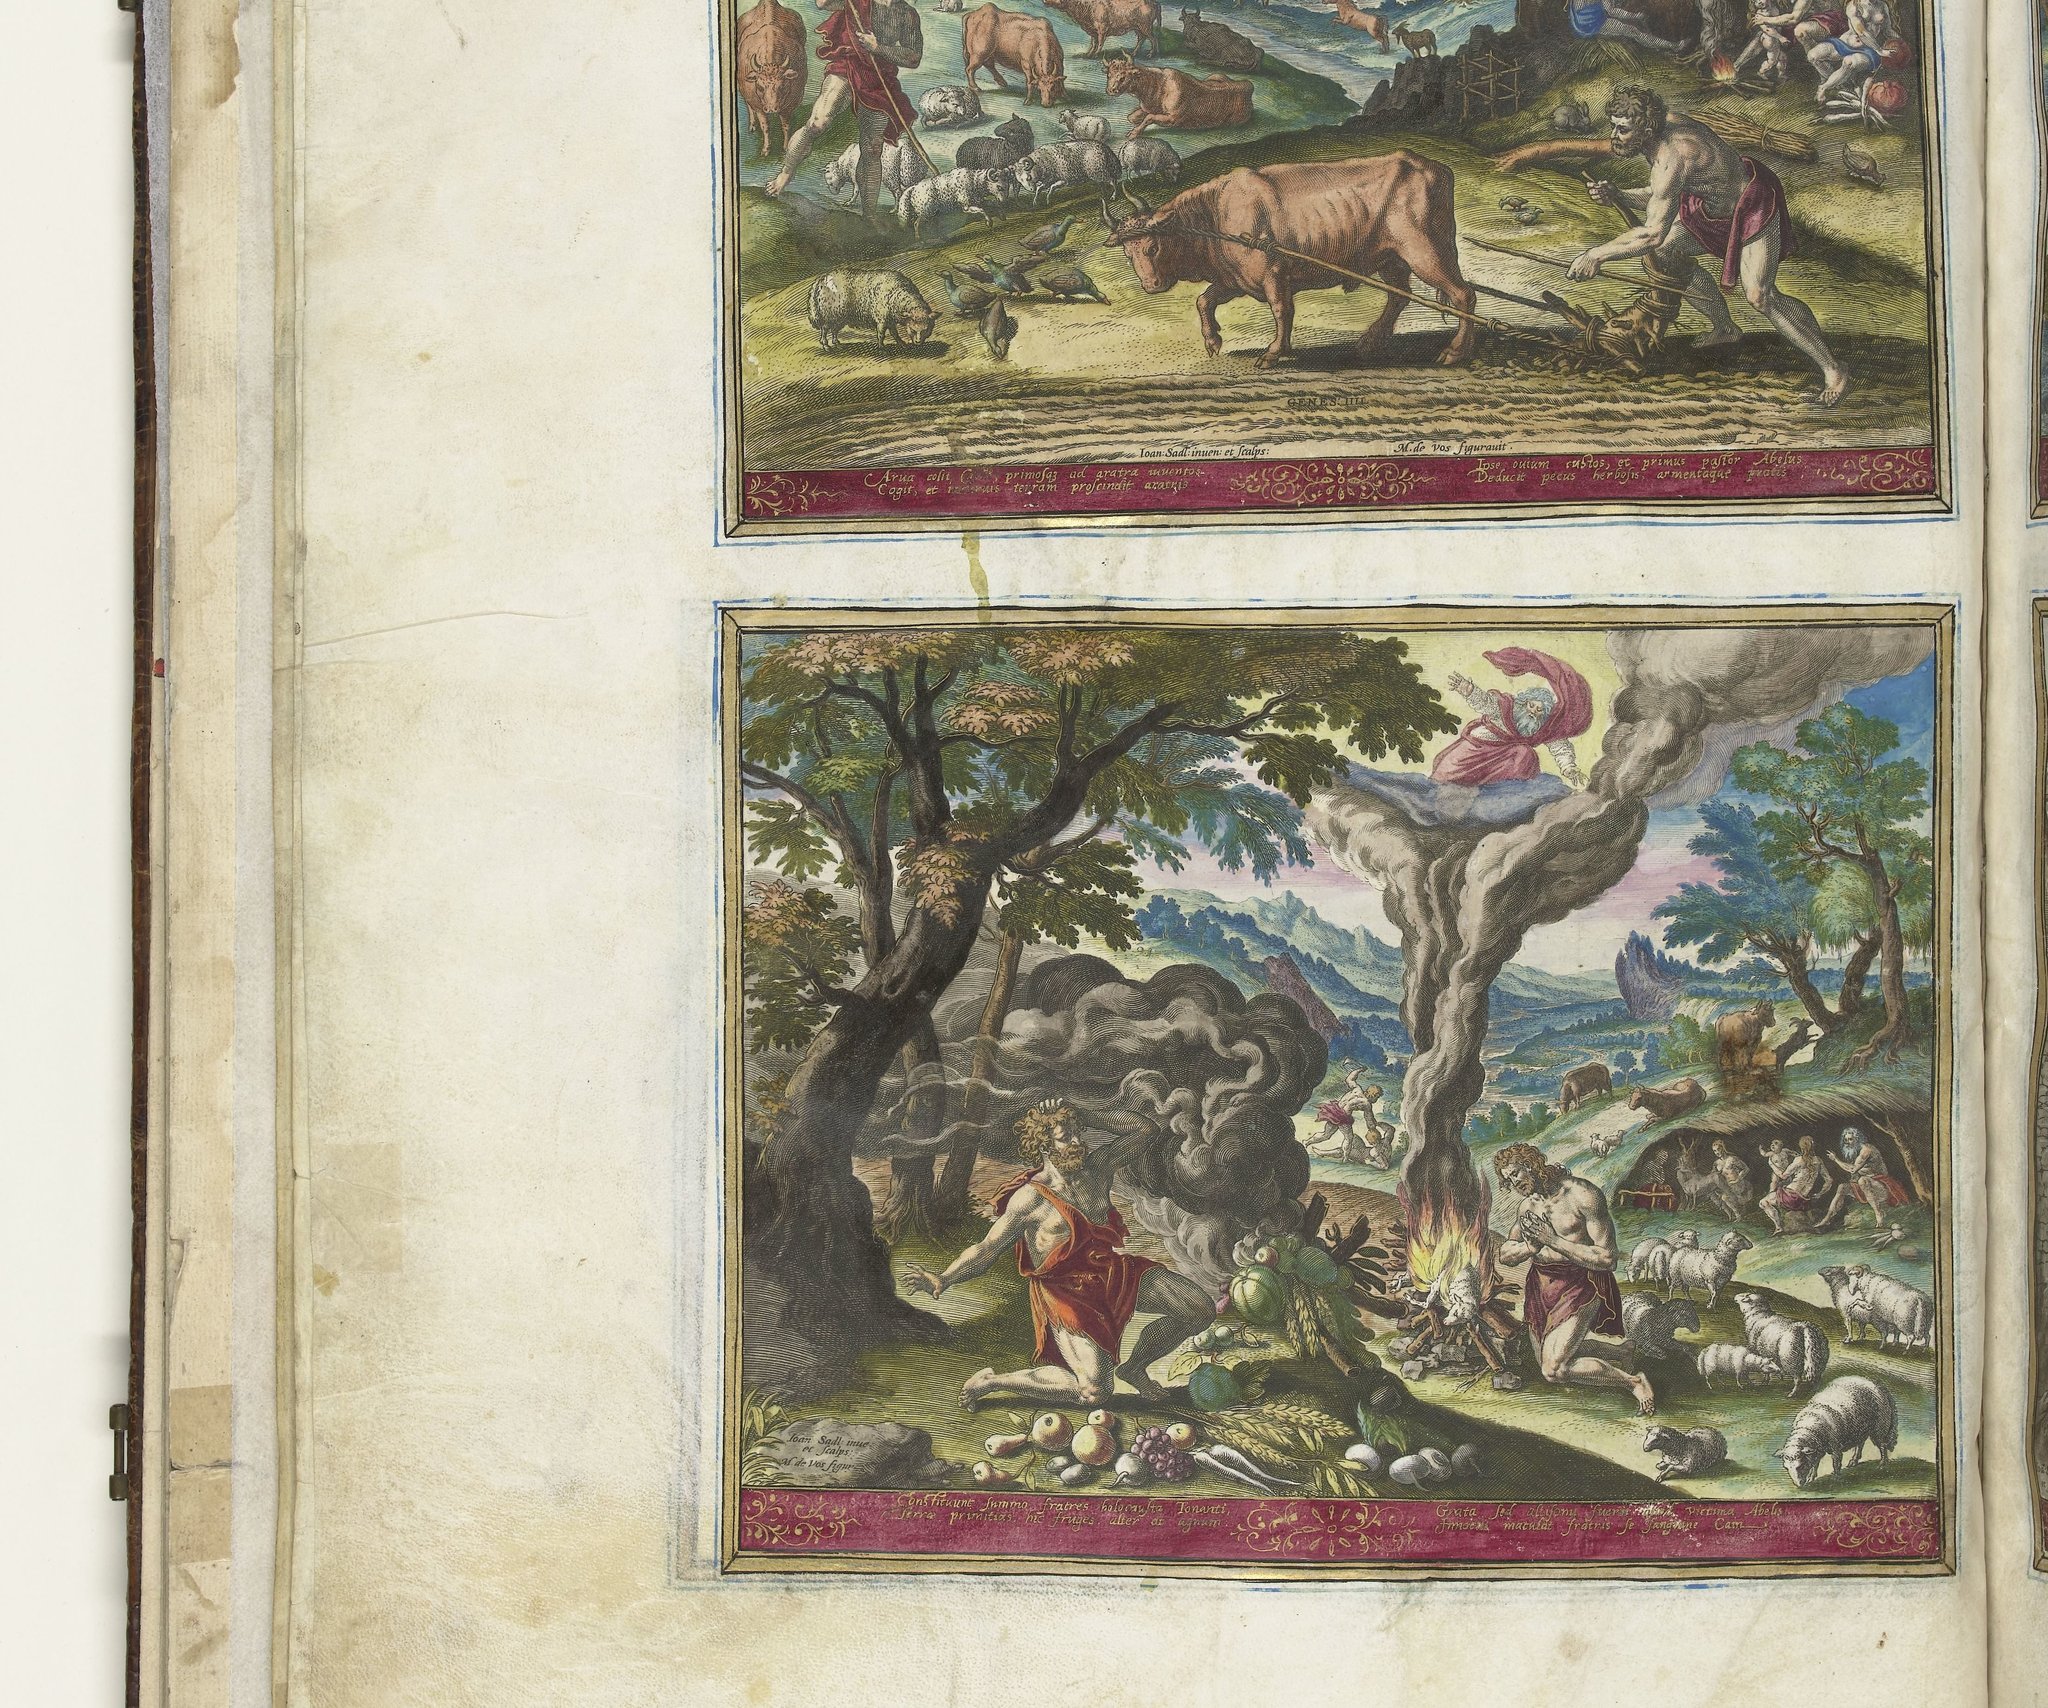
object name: print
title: Boni et mali scientia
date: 1583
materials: paper, parchment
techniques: engraving, hand coloring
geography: antwerp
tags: abel (alone) at work, herding, cain (alone) at work, farming, herd, flock, ploughing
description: Kaïn ploegt een veld met een trekos. Abel zorgt voor een kudde koeien en schapen. Op de achtergrond rechts de hut van Adam en Eva. Onder de voorstelling een verklarende tekst in het Latijn. Deze prent maakt deel uit van een album.